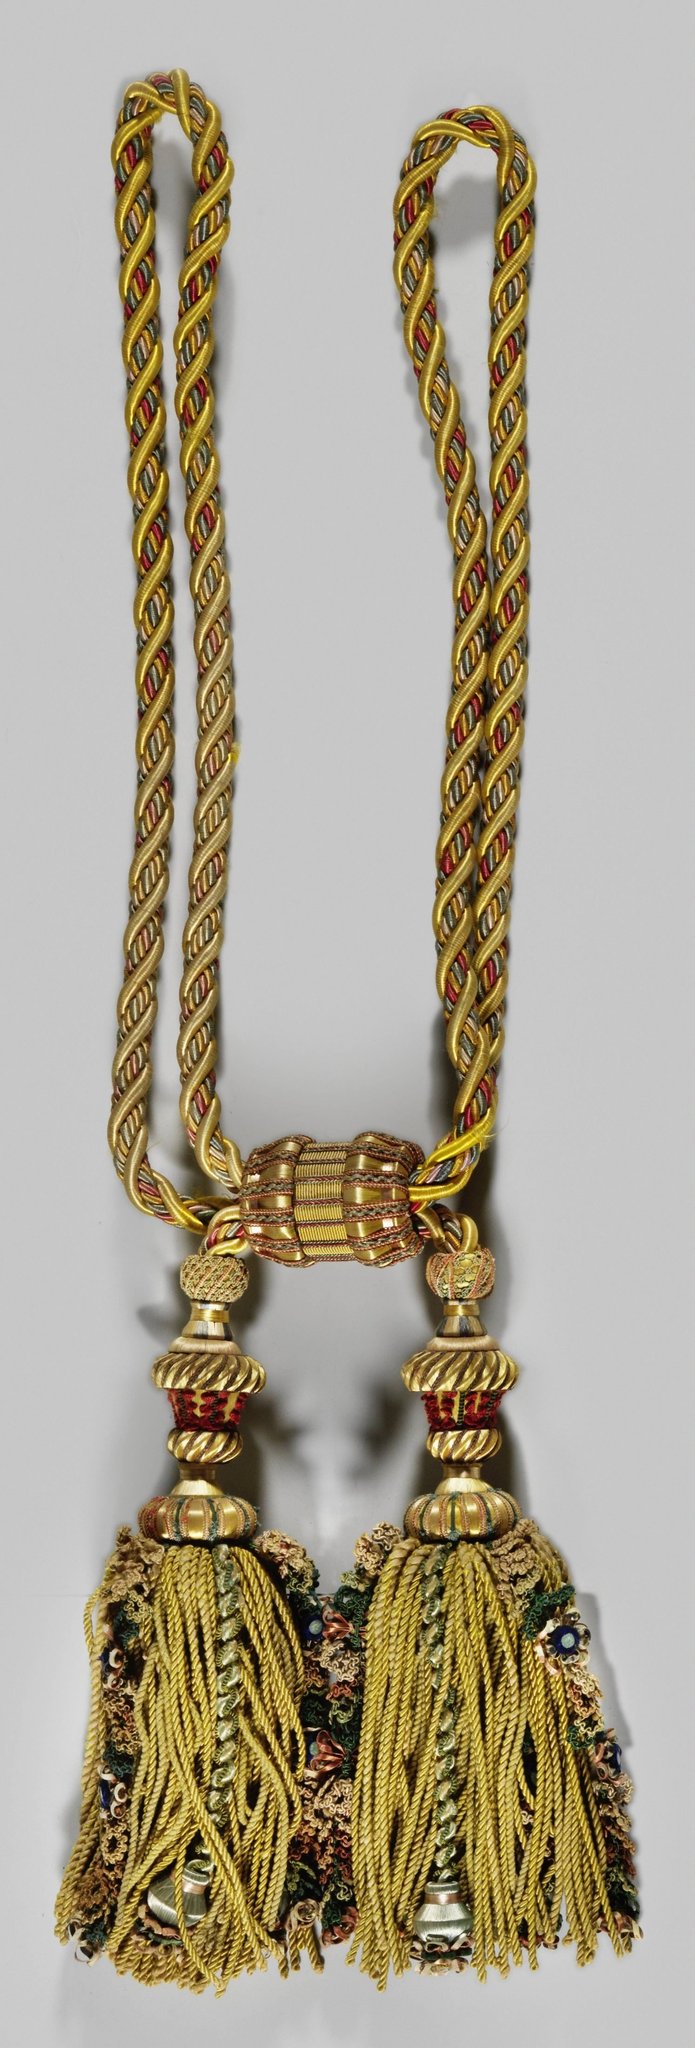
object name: tieback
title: Embrasse behorend bij een stel gordijnen met bloemdessin op geel fond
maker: carel hubertus windt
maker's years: 1804-1860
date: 1850-1860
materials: silk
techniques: lampas, weave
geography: lyon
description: Embrasse behorend bij een stel gordijnen van zijde met bloemdessin op geel fond, afkomstig uit de kleine danszaal van Paleis Noordeinde.